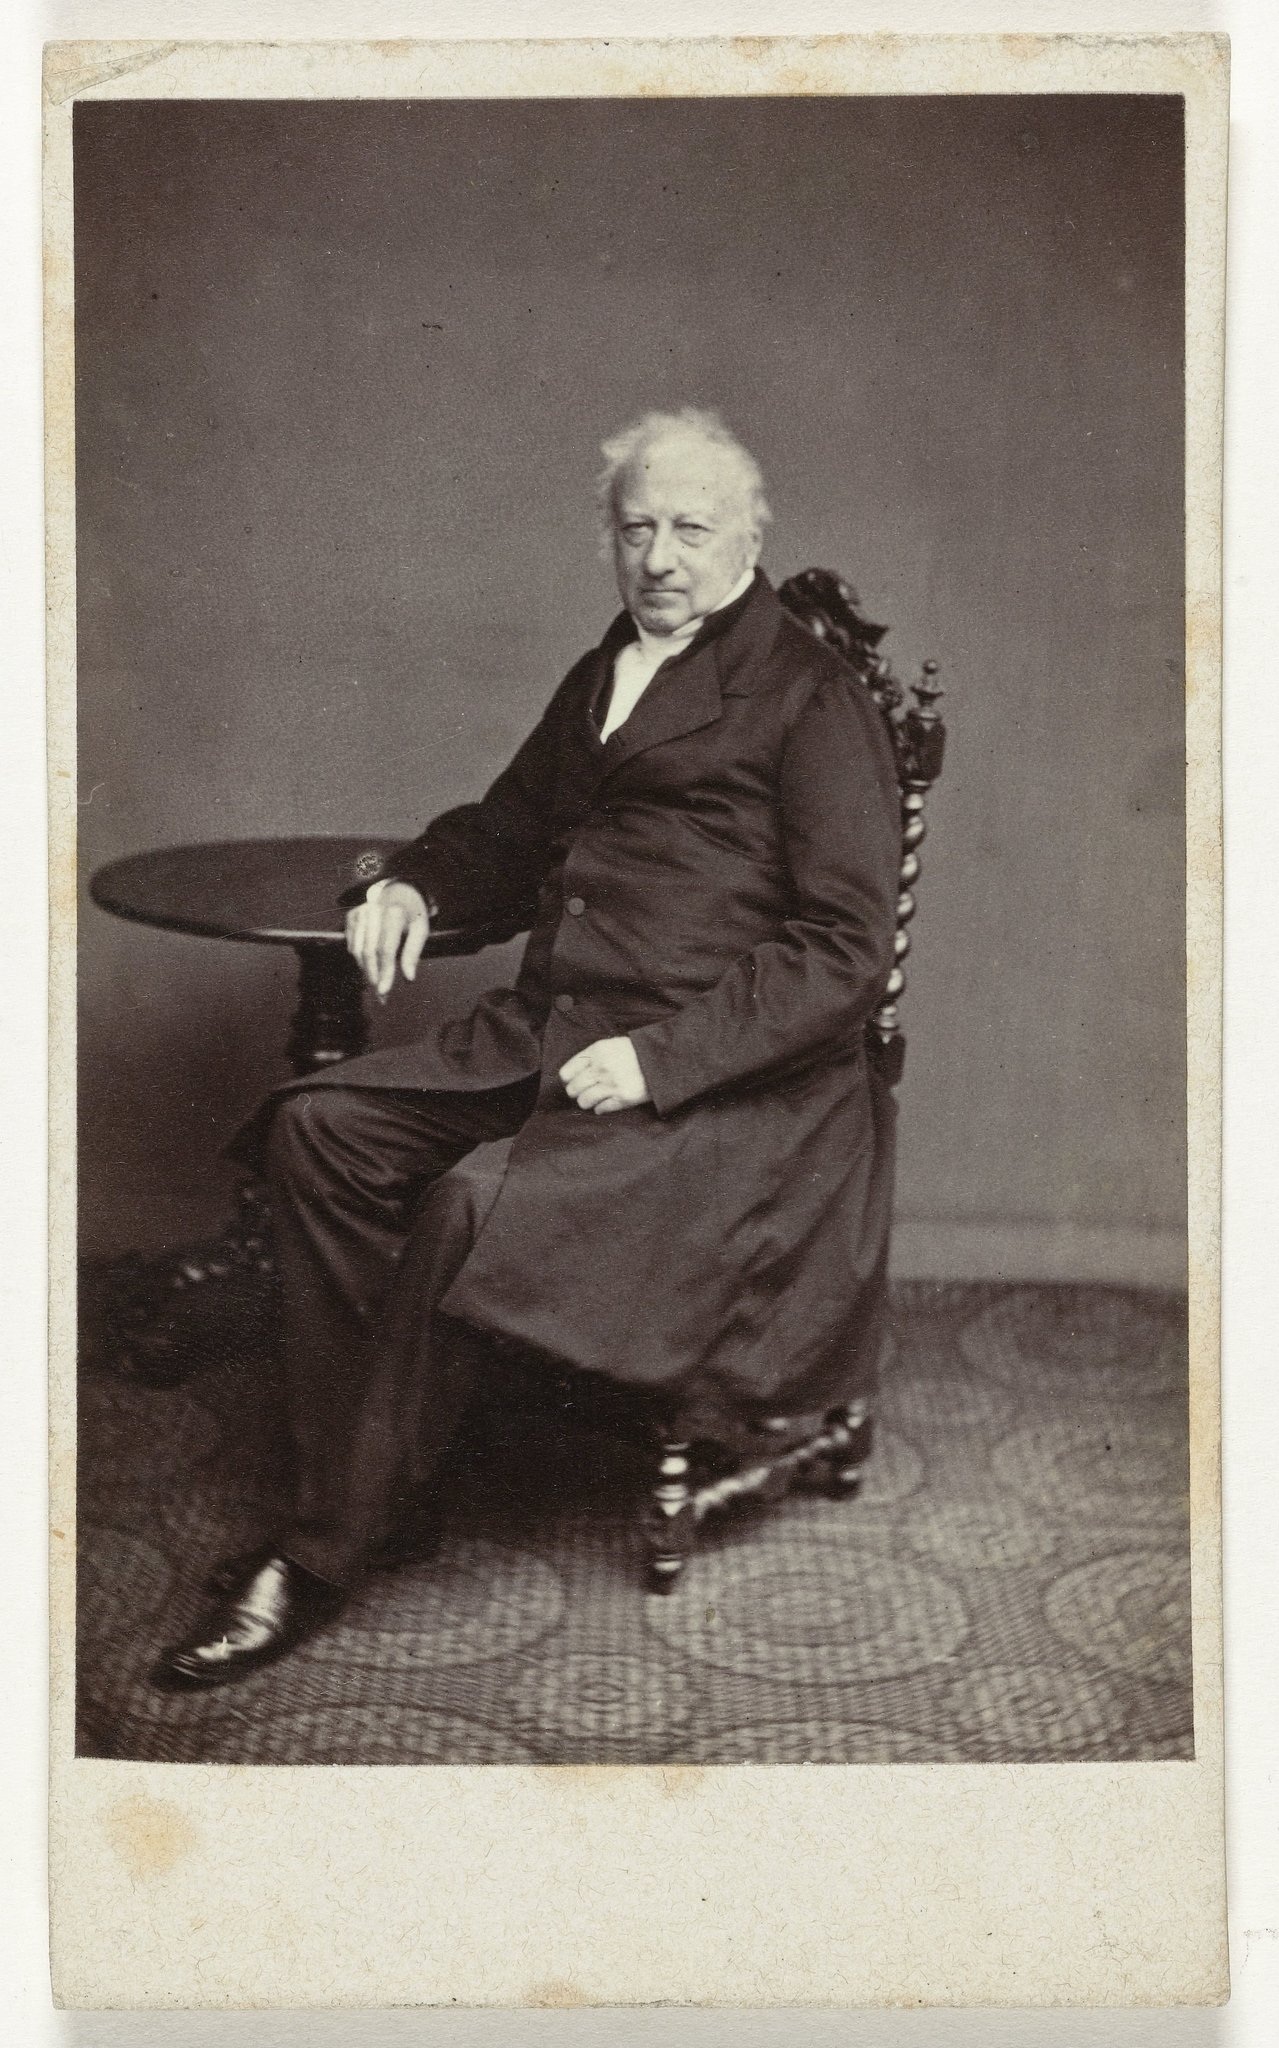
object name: carte de visite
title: Cartes-de-visite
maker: gerrit hoogwinkel jr.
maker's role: fotograaf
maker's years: 1837-1890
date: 1860-1865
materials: cardboard, paper, photographic support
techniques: albumen print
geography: rotterdam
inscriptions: address: ‘G. Hoogwinkel/Photographe/Rotterdam’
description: Cartomanie was a collecting craze. From 1855 hundreds of thousands of these portraits were annually sold worldwide. People had photographs taken of their loved ones, including their pets, and kept them in an album. Portraits of kings, writers, artists, actors, and statesmen were also collected. Photography was no longer the preserve of the wealthy; farmers and maidservants now also stood before the camera.